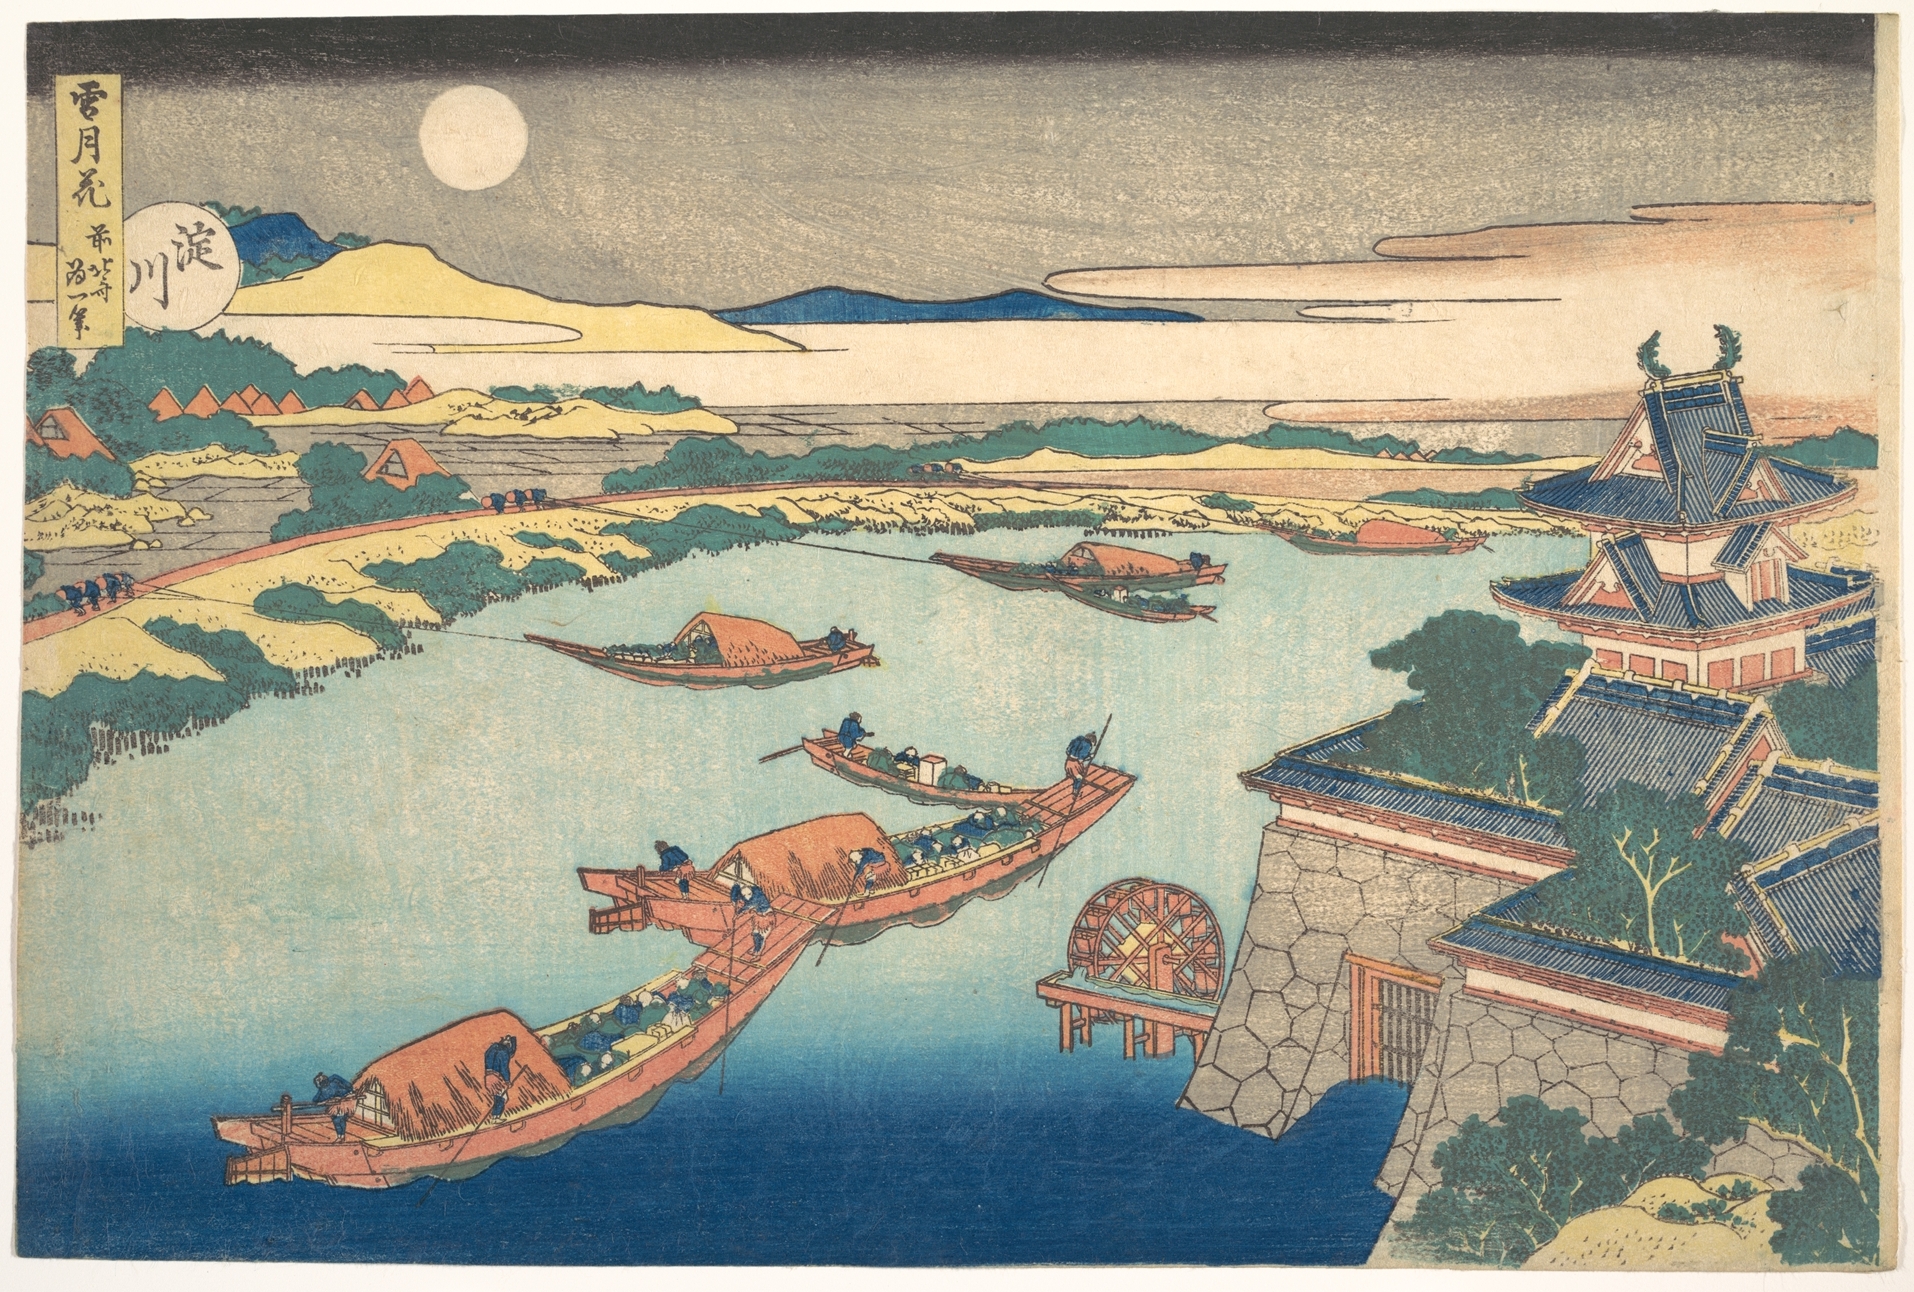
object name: woodblock print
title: Moonlight on the Yodo River (Yodogawa), from the series Snow, Moon, and Flowers (Setsugekka)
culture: japanese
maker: katsushika hokusai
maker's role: artist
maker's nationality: japanese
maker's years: 1760-1849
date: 1833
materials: ink, paper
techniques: woodblock print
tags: human figures,rivers,moon,trees,boats